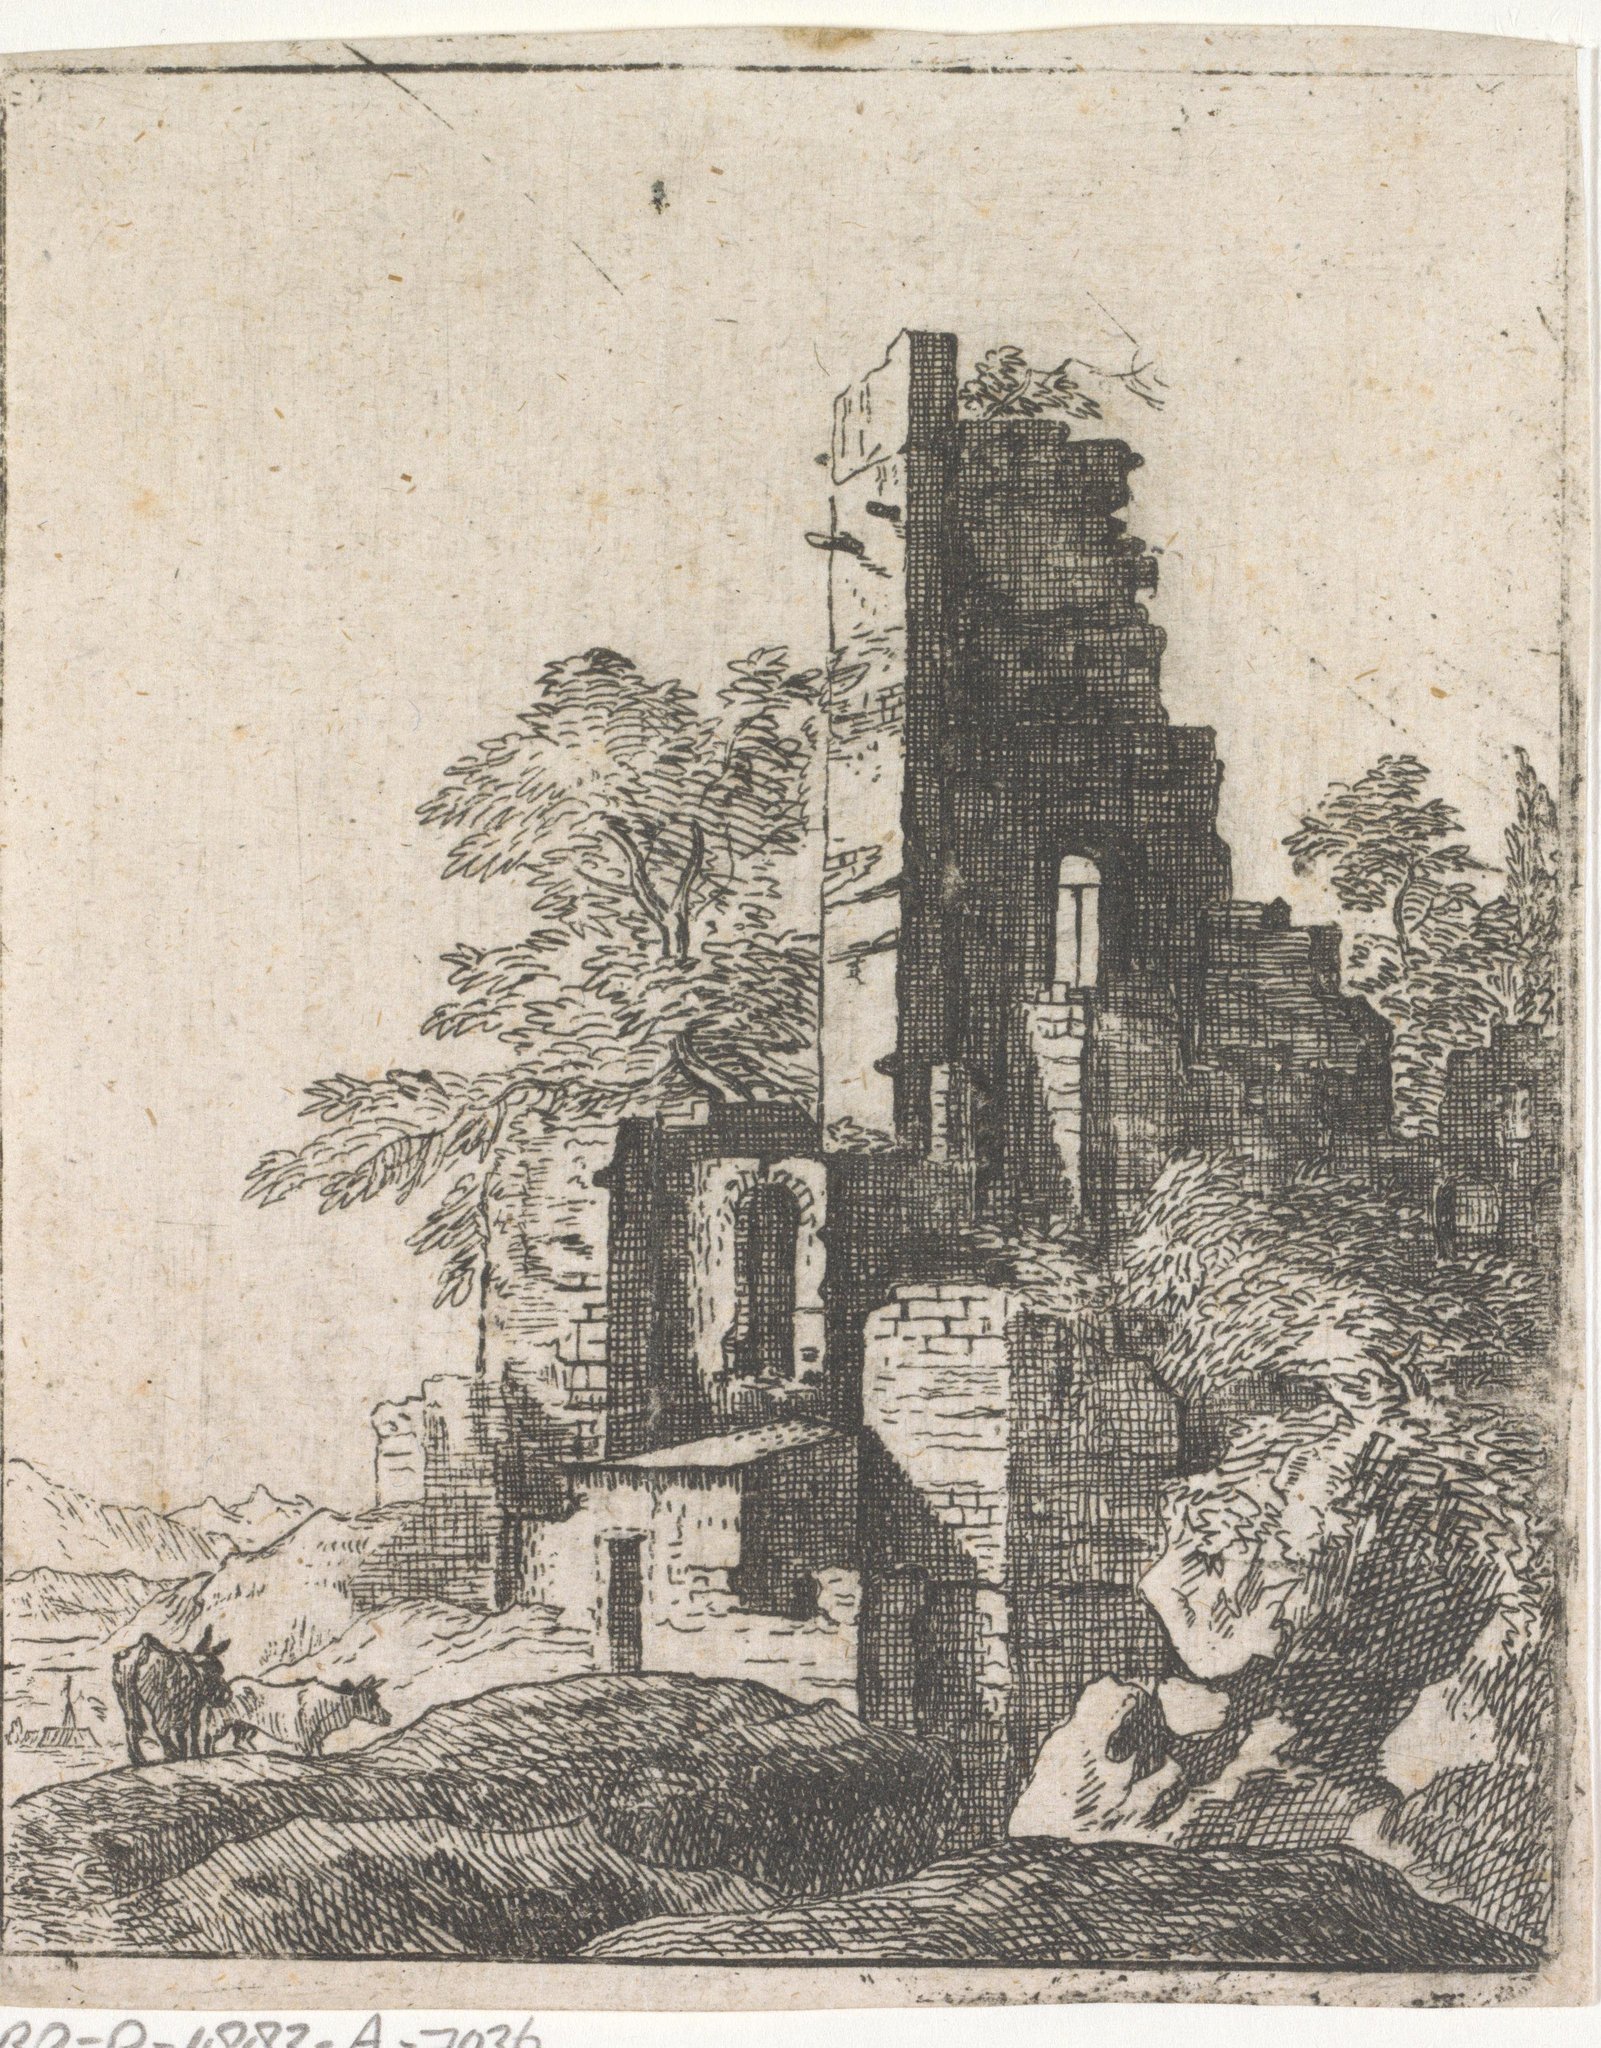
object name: print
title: Landschap met ruïne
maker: Anonymous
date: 1600-1700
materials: paper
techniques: etching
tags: landscape with ruins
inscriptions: collector's mark: Lugt 2228, collector's mark: Lugt 1204